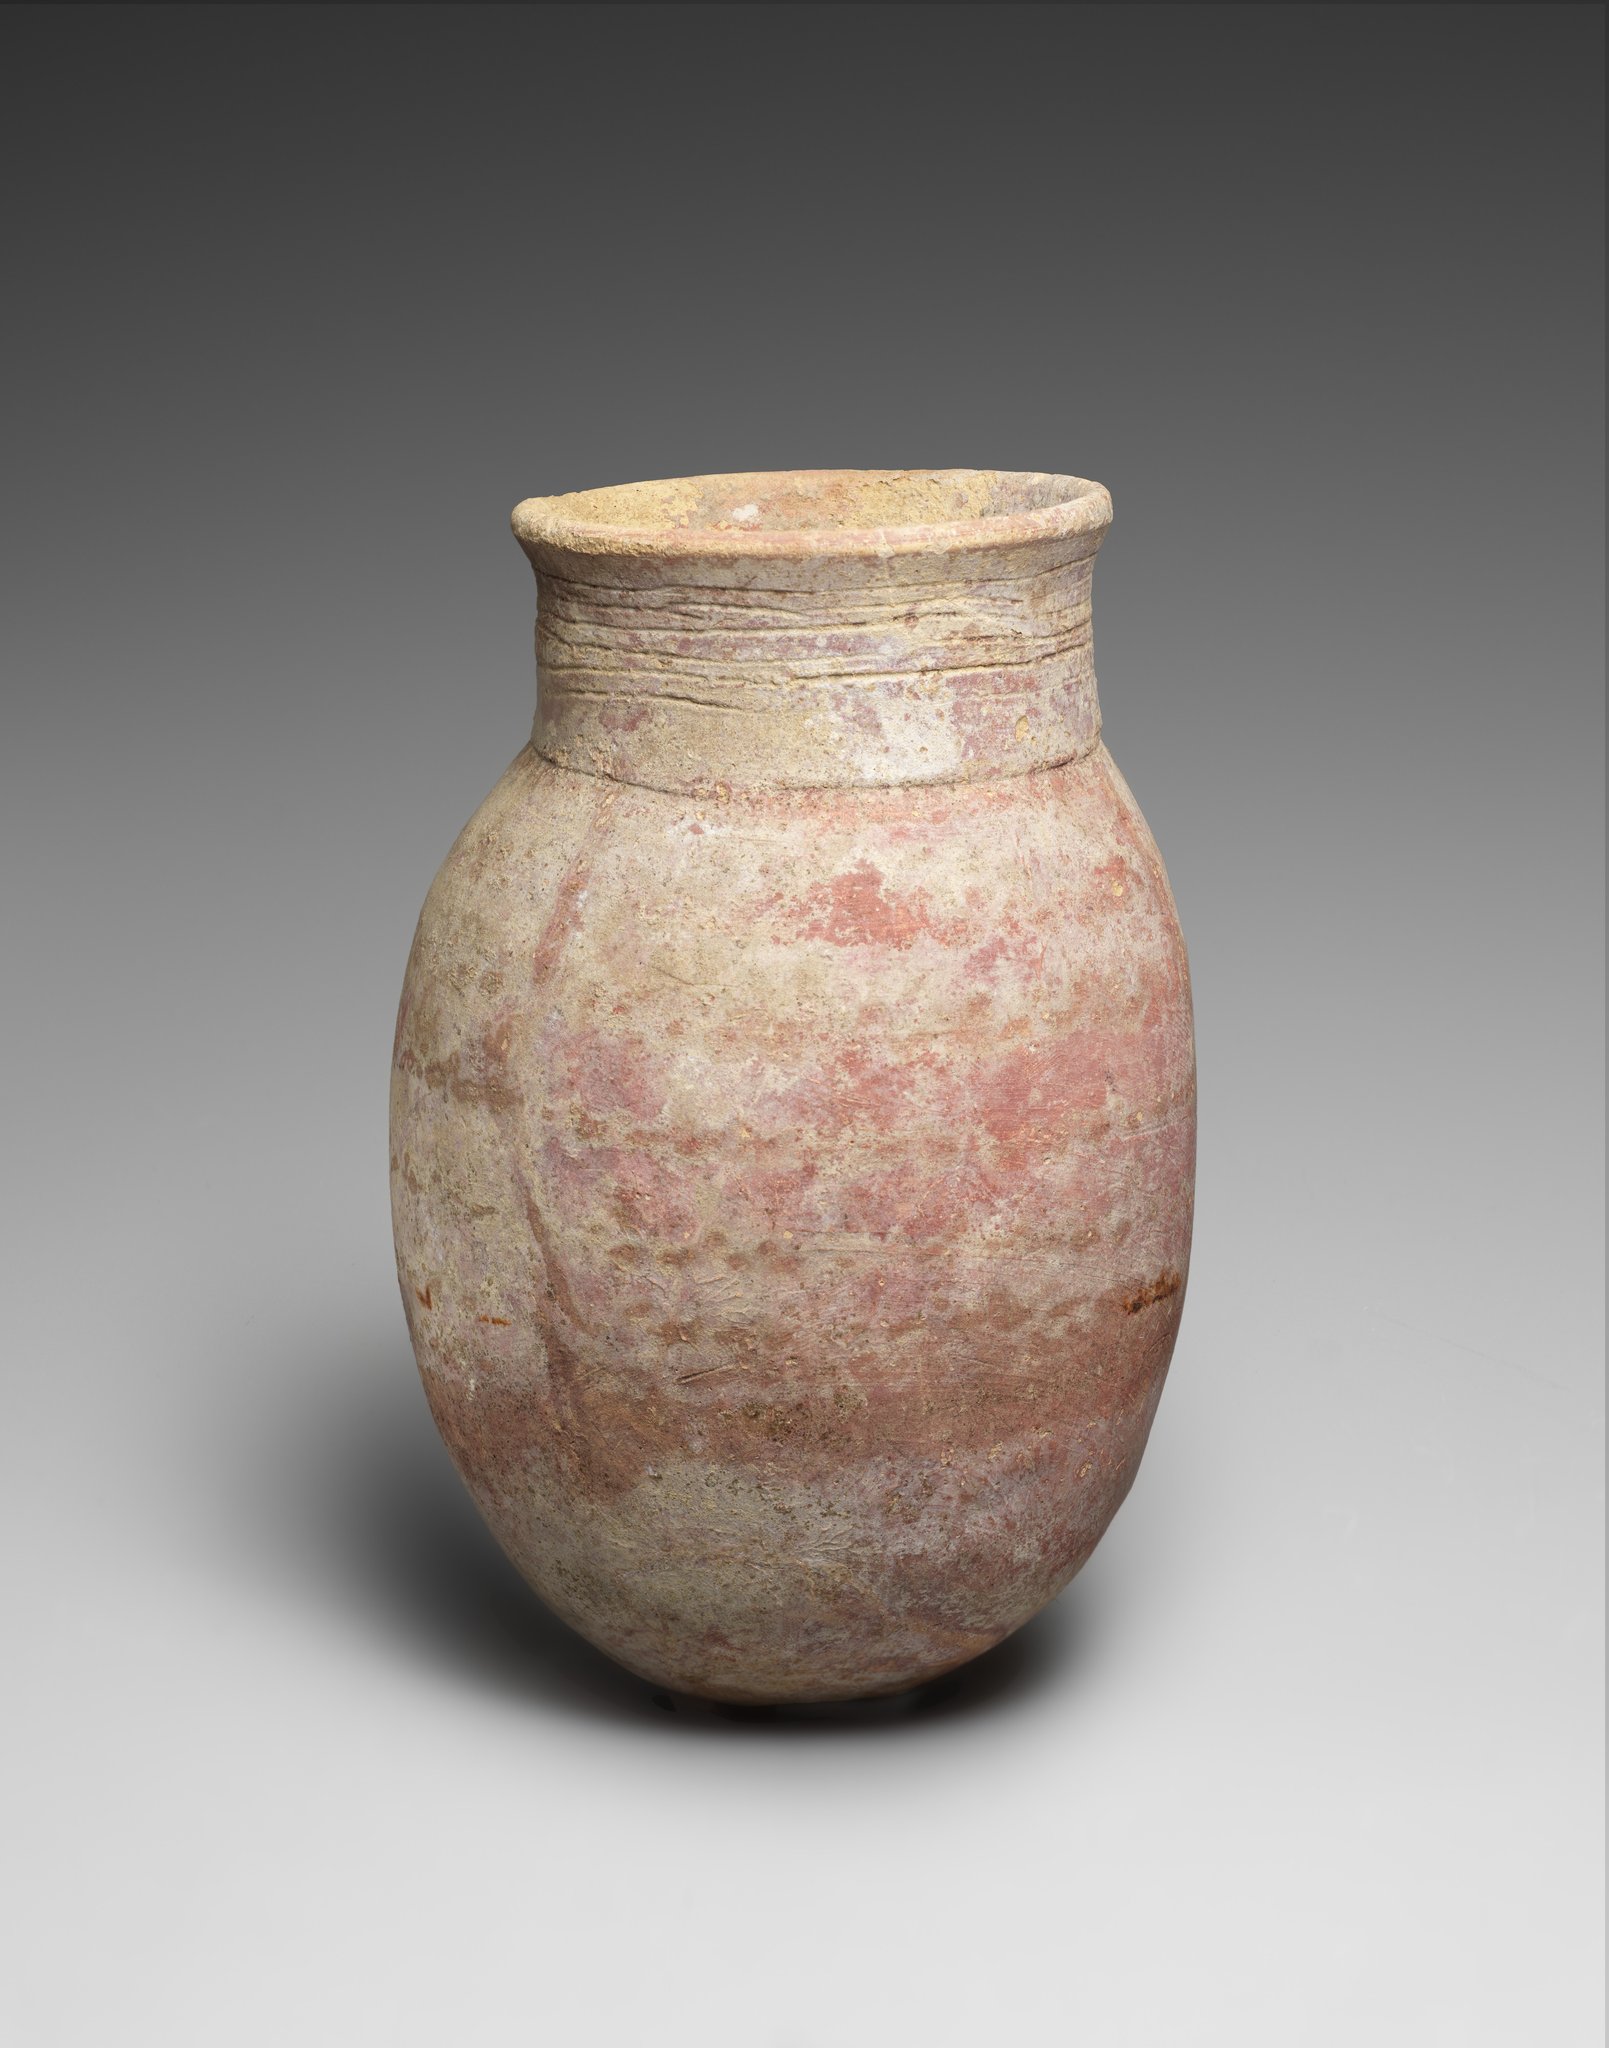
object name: vessel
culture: dilmun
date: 3000-2001 BCE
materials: ceramic, paint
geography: bahrain (ancient dilmun)